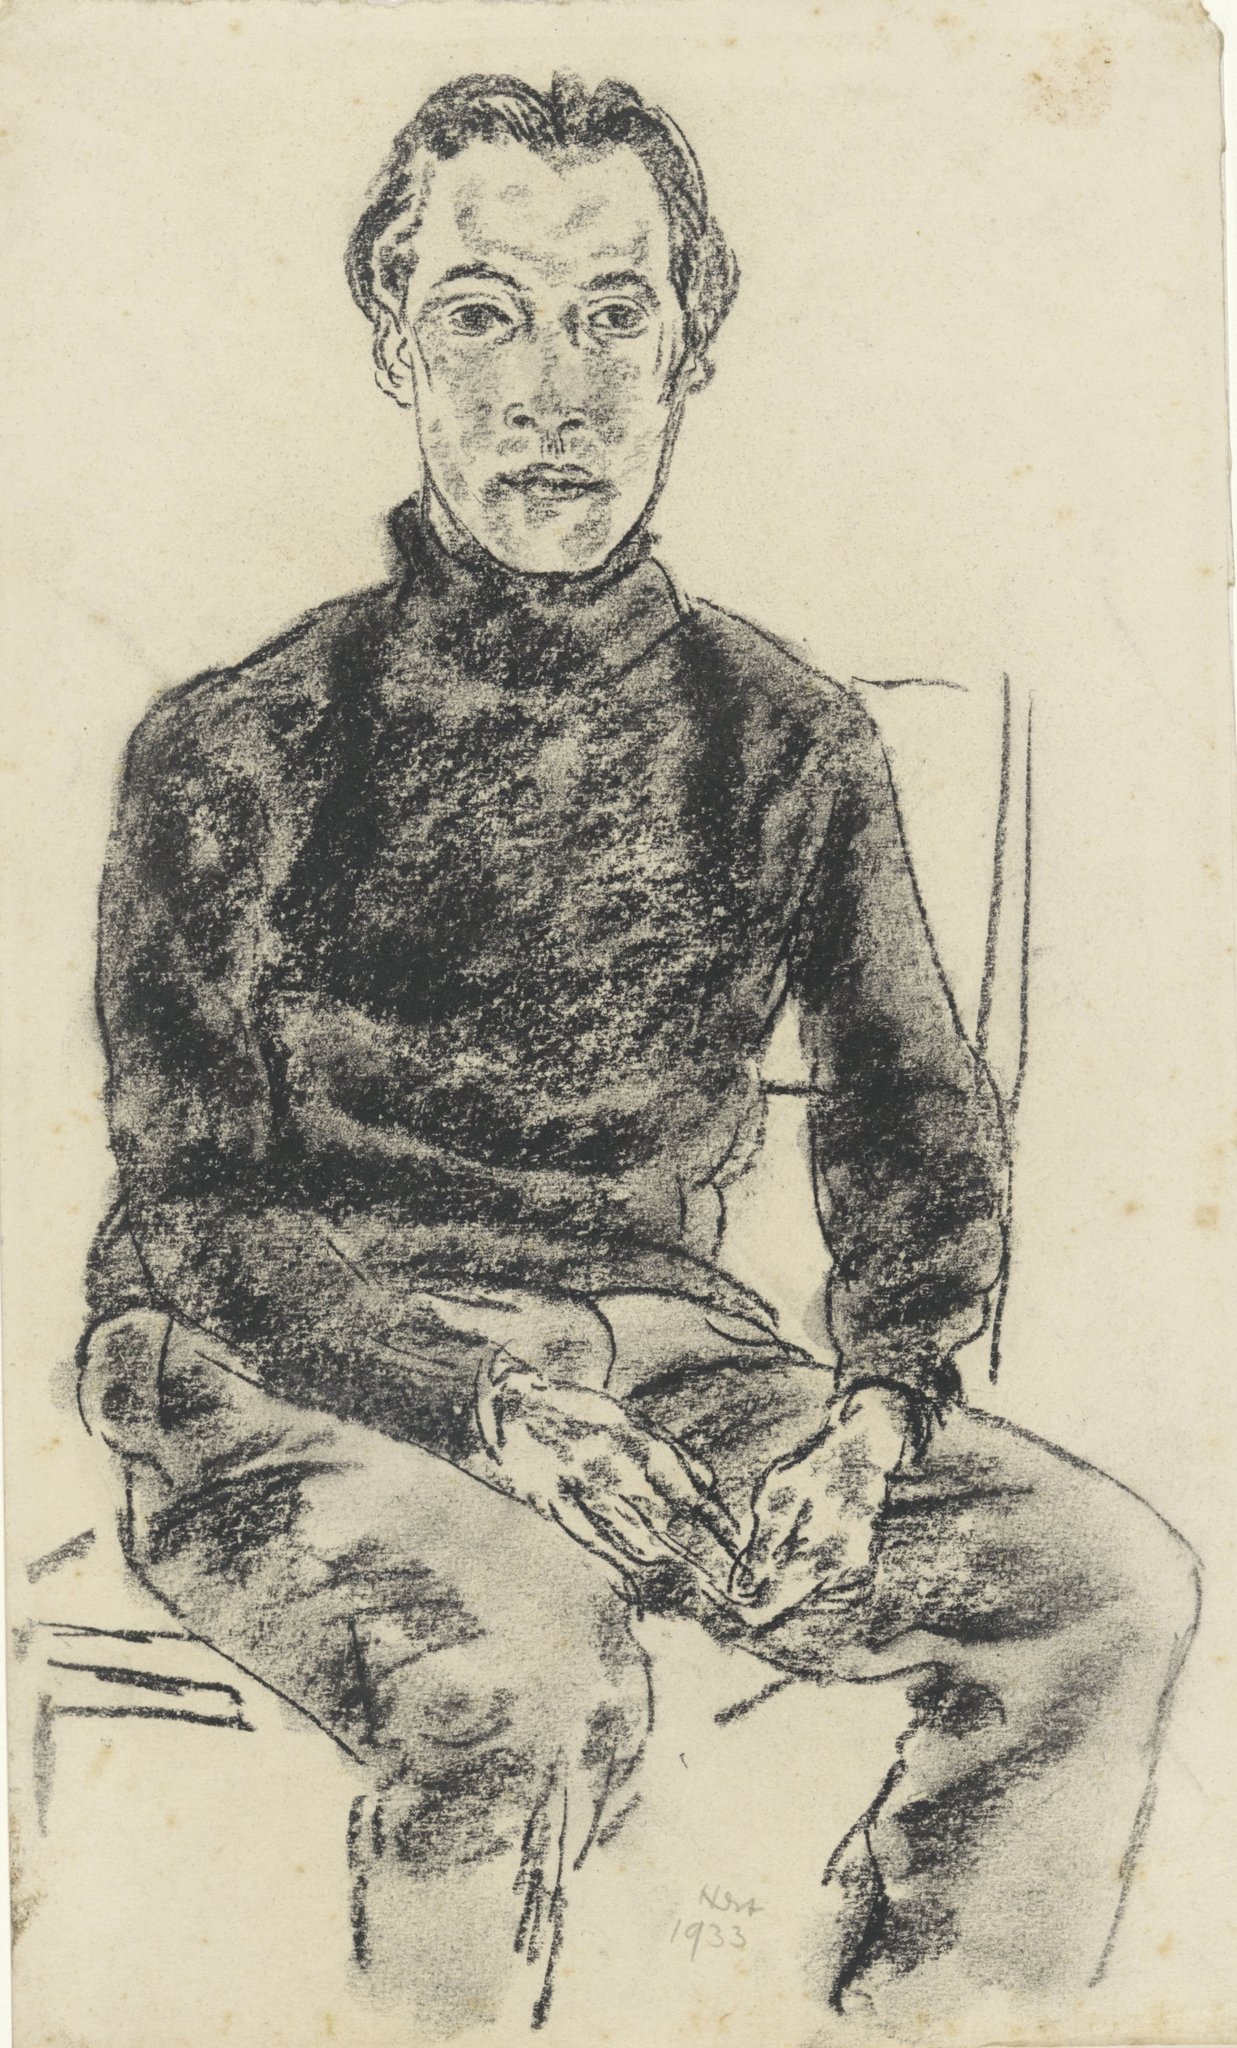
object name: drawing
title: Zittende man op een stoel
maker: henk henriët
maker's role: draughtsman, print maker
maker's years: 1903-1945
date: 1933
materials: chalk, paper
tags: the (nude) human figure; 'corpo humano' (ripa) (+ sitting), chair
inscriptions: collector's mark: Lugt 2228